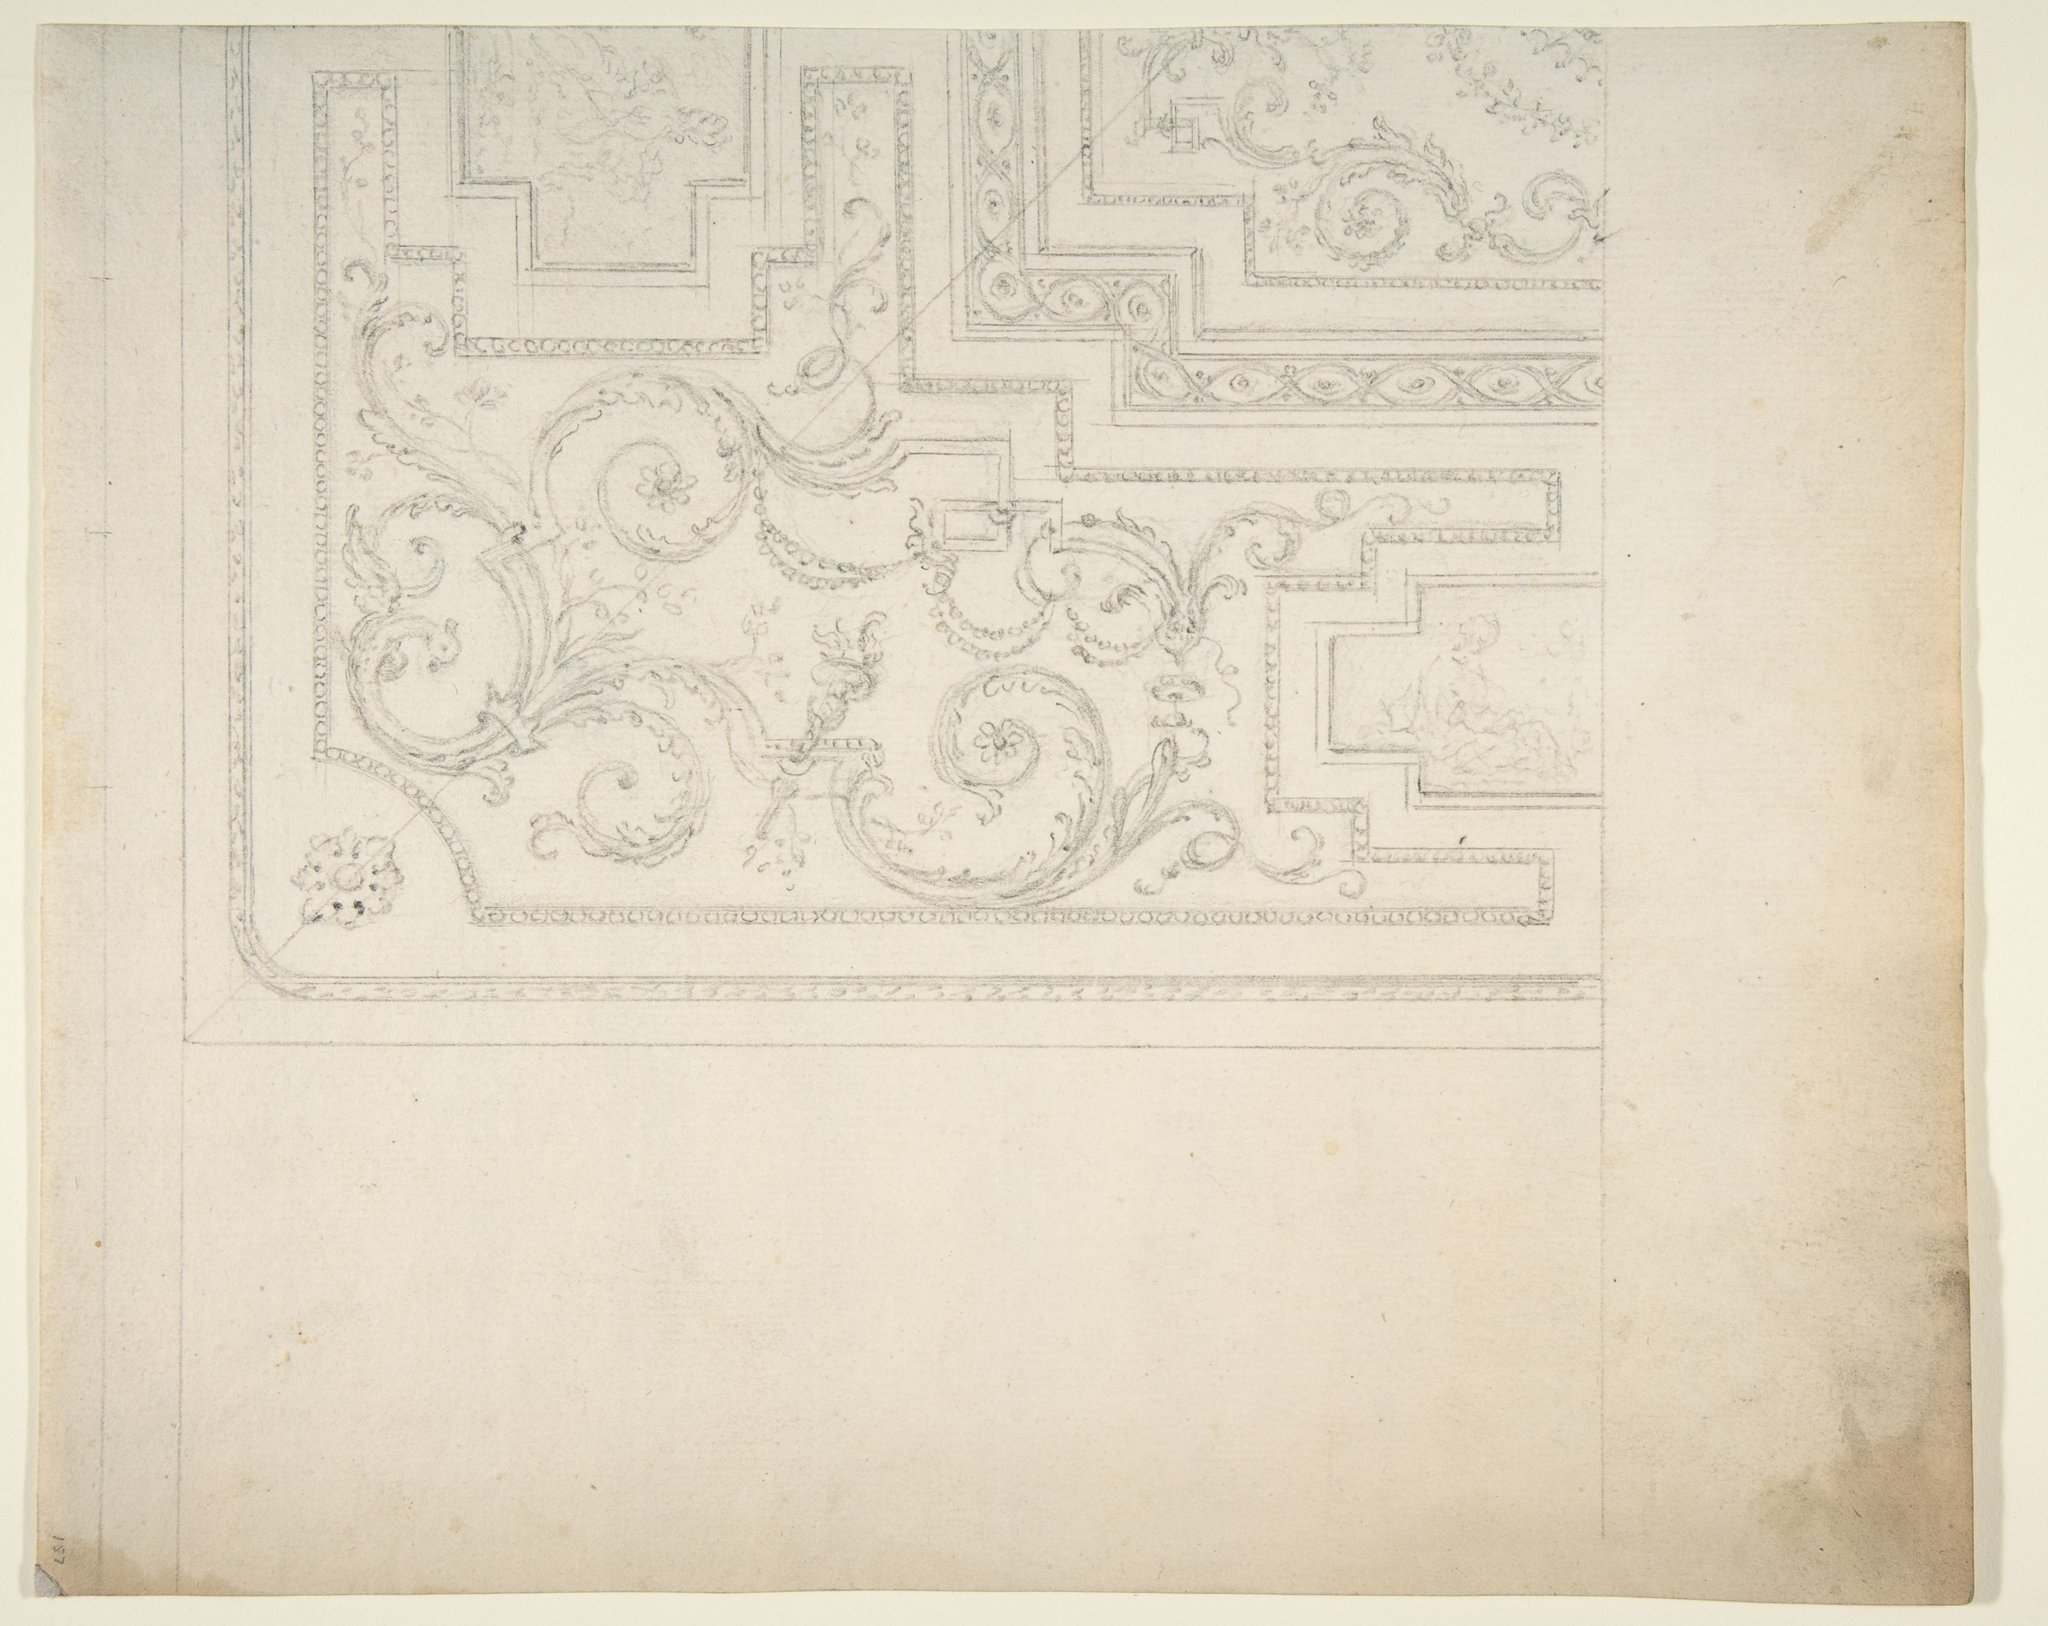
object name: drawing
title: Design for Ceiling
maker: leonardo marini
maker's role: artist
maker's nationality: italian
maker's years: 1730-1797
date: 1701-1800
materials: graphite, drawing material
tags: ornament